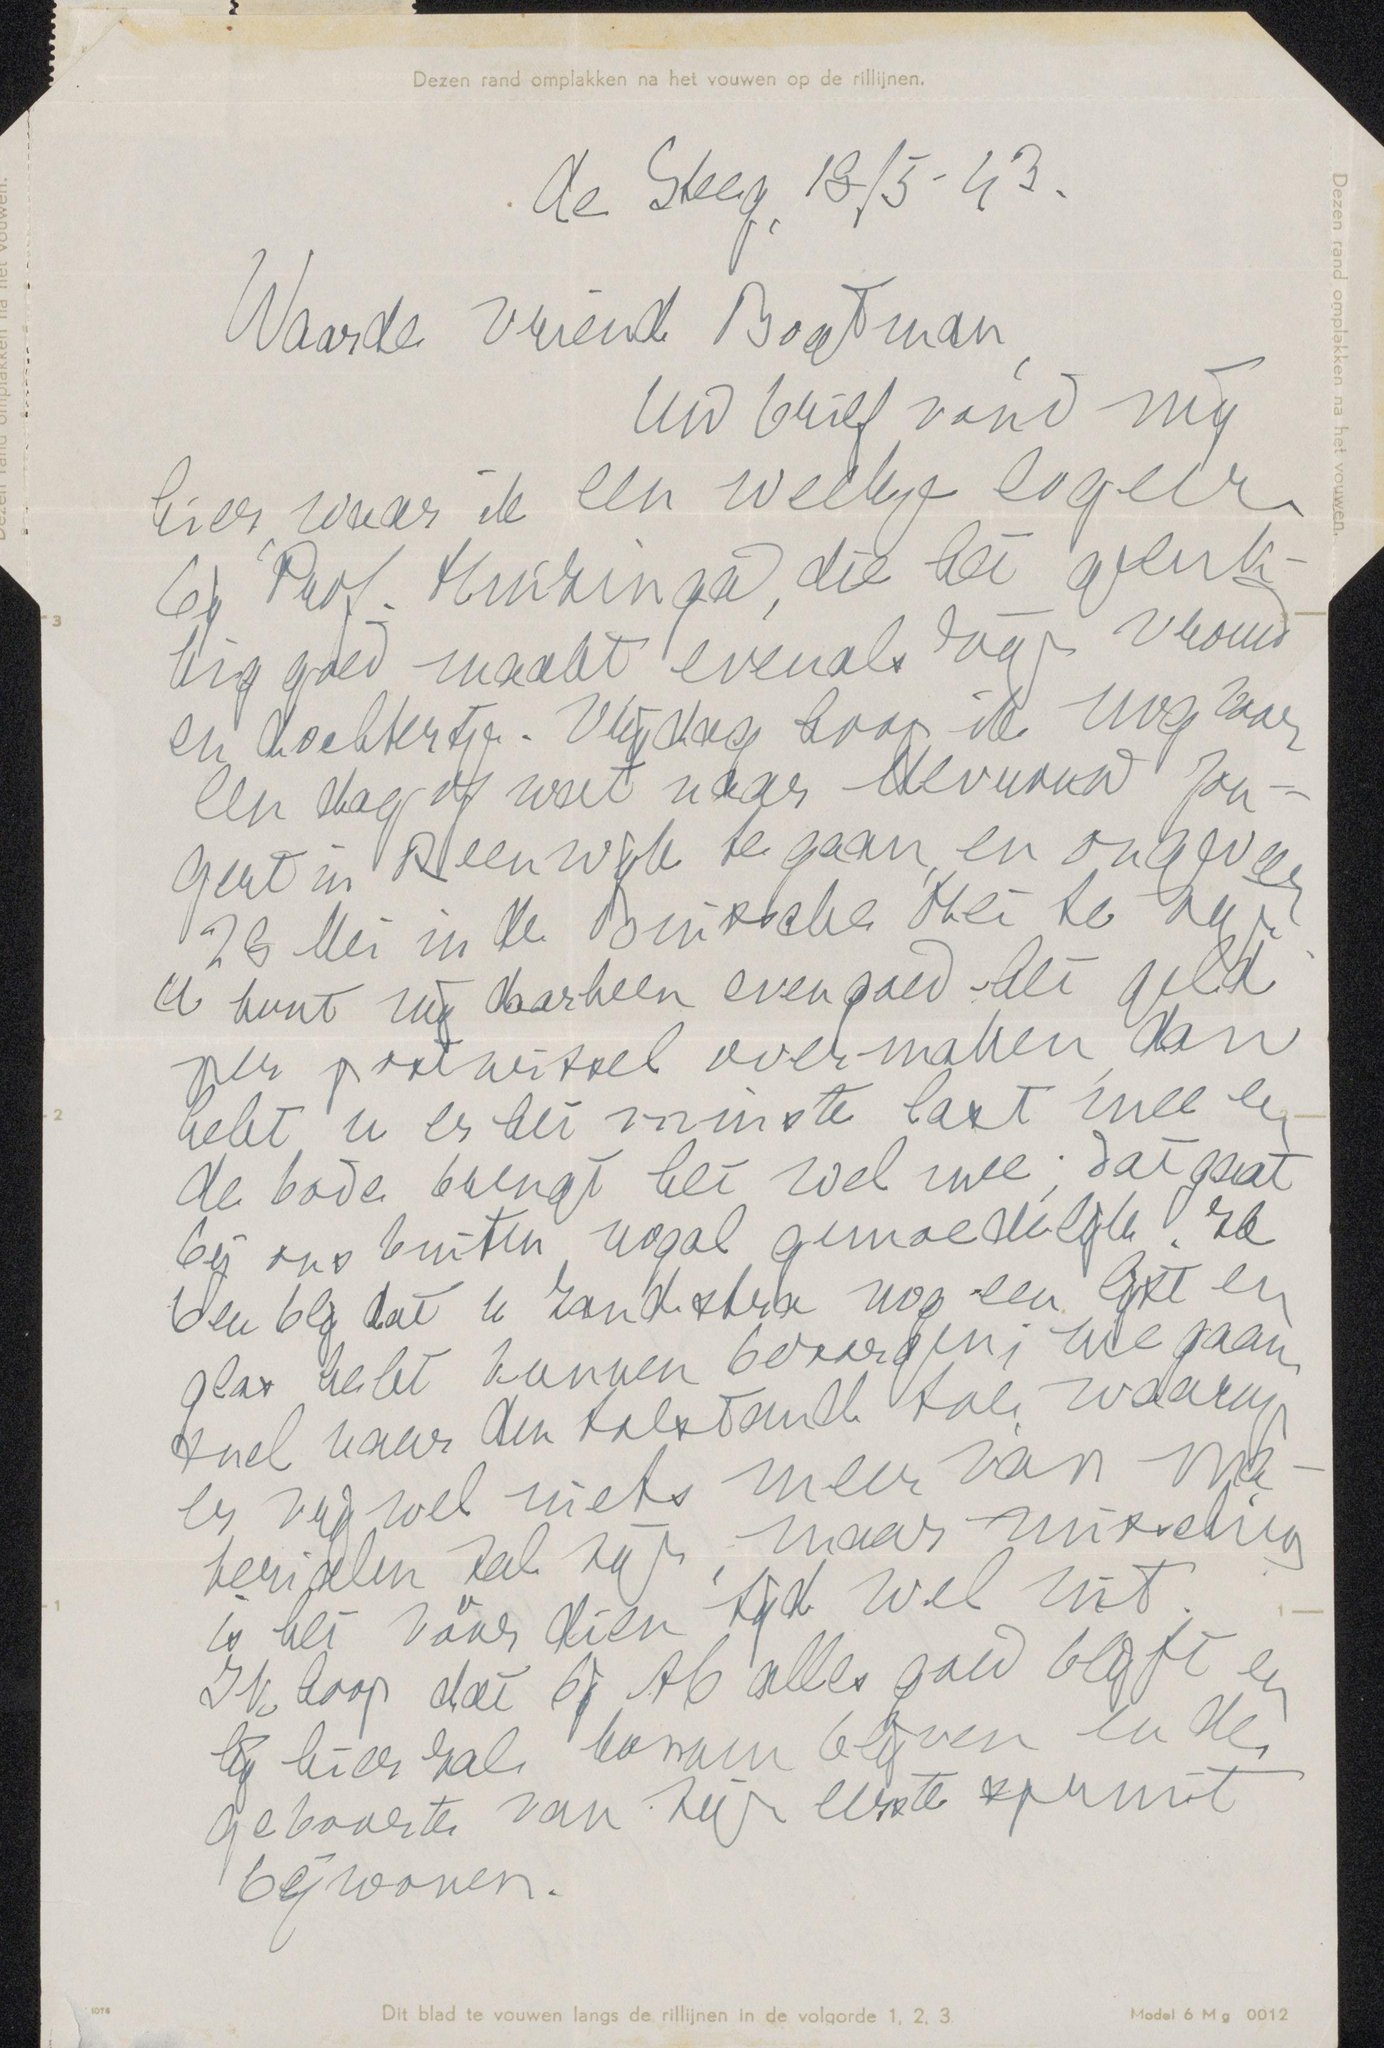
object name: letter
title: Brief aan Willem Bogtman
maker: henriëtte roland holst-van der schalk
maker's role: dichter, schrijver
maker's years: 1869-1952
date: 1943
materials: ink, paper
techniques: pen, writing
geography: de steeg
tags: haarlem, willem bogtman, johan huizinga, family life, money, amsterdam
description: Brief bevat bewijs van storting voor een postwissel.